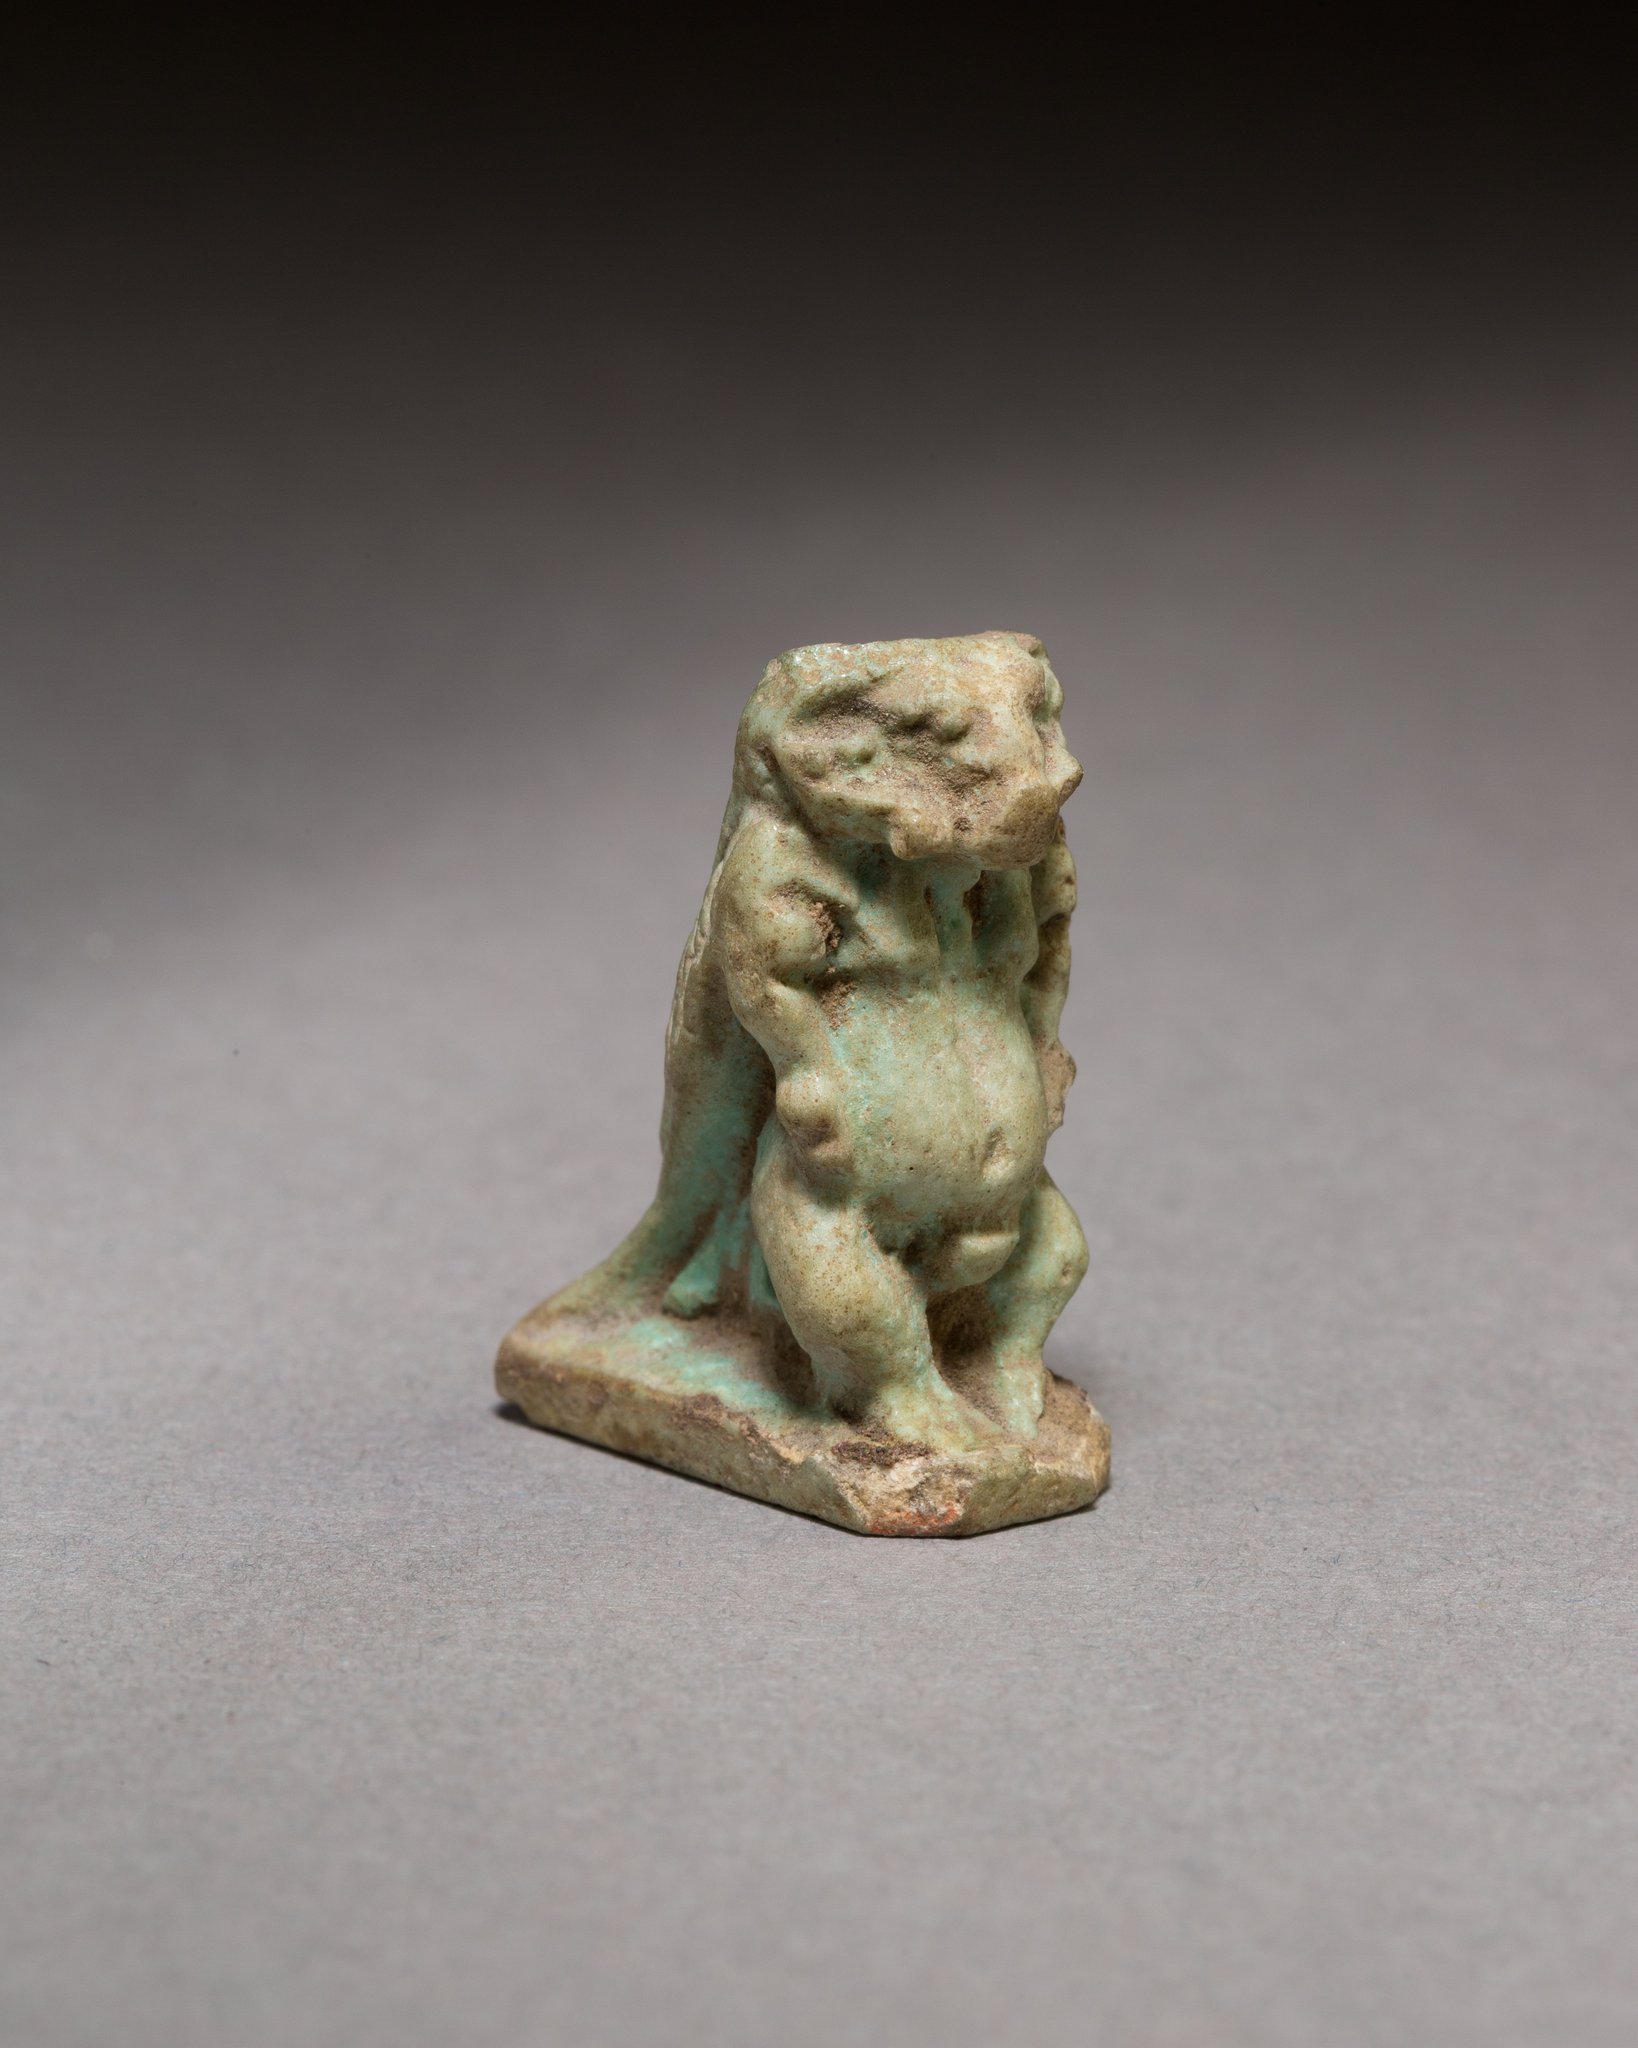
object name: amulet, polymorphic deity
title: Polymorphic deity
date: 664-630 BCE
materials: faience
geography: egypt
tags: deities